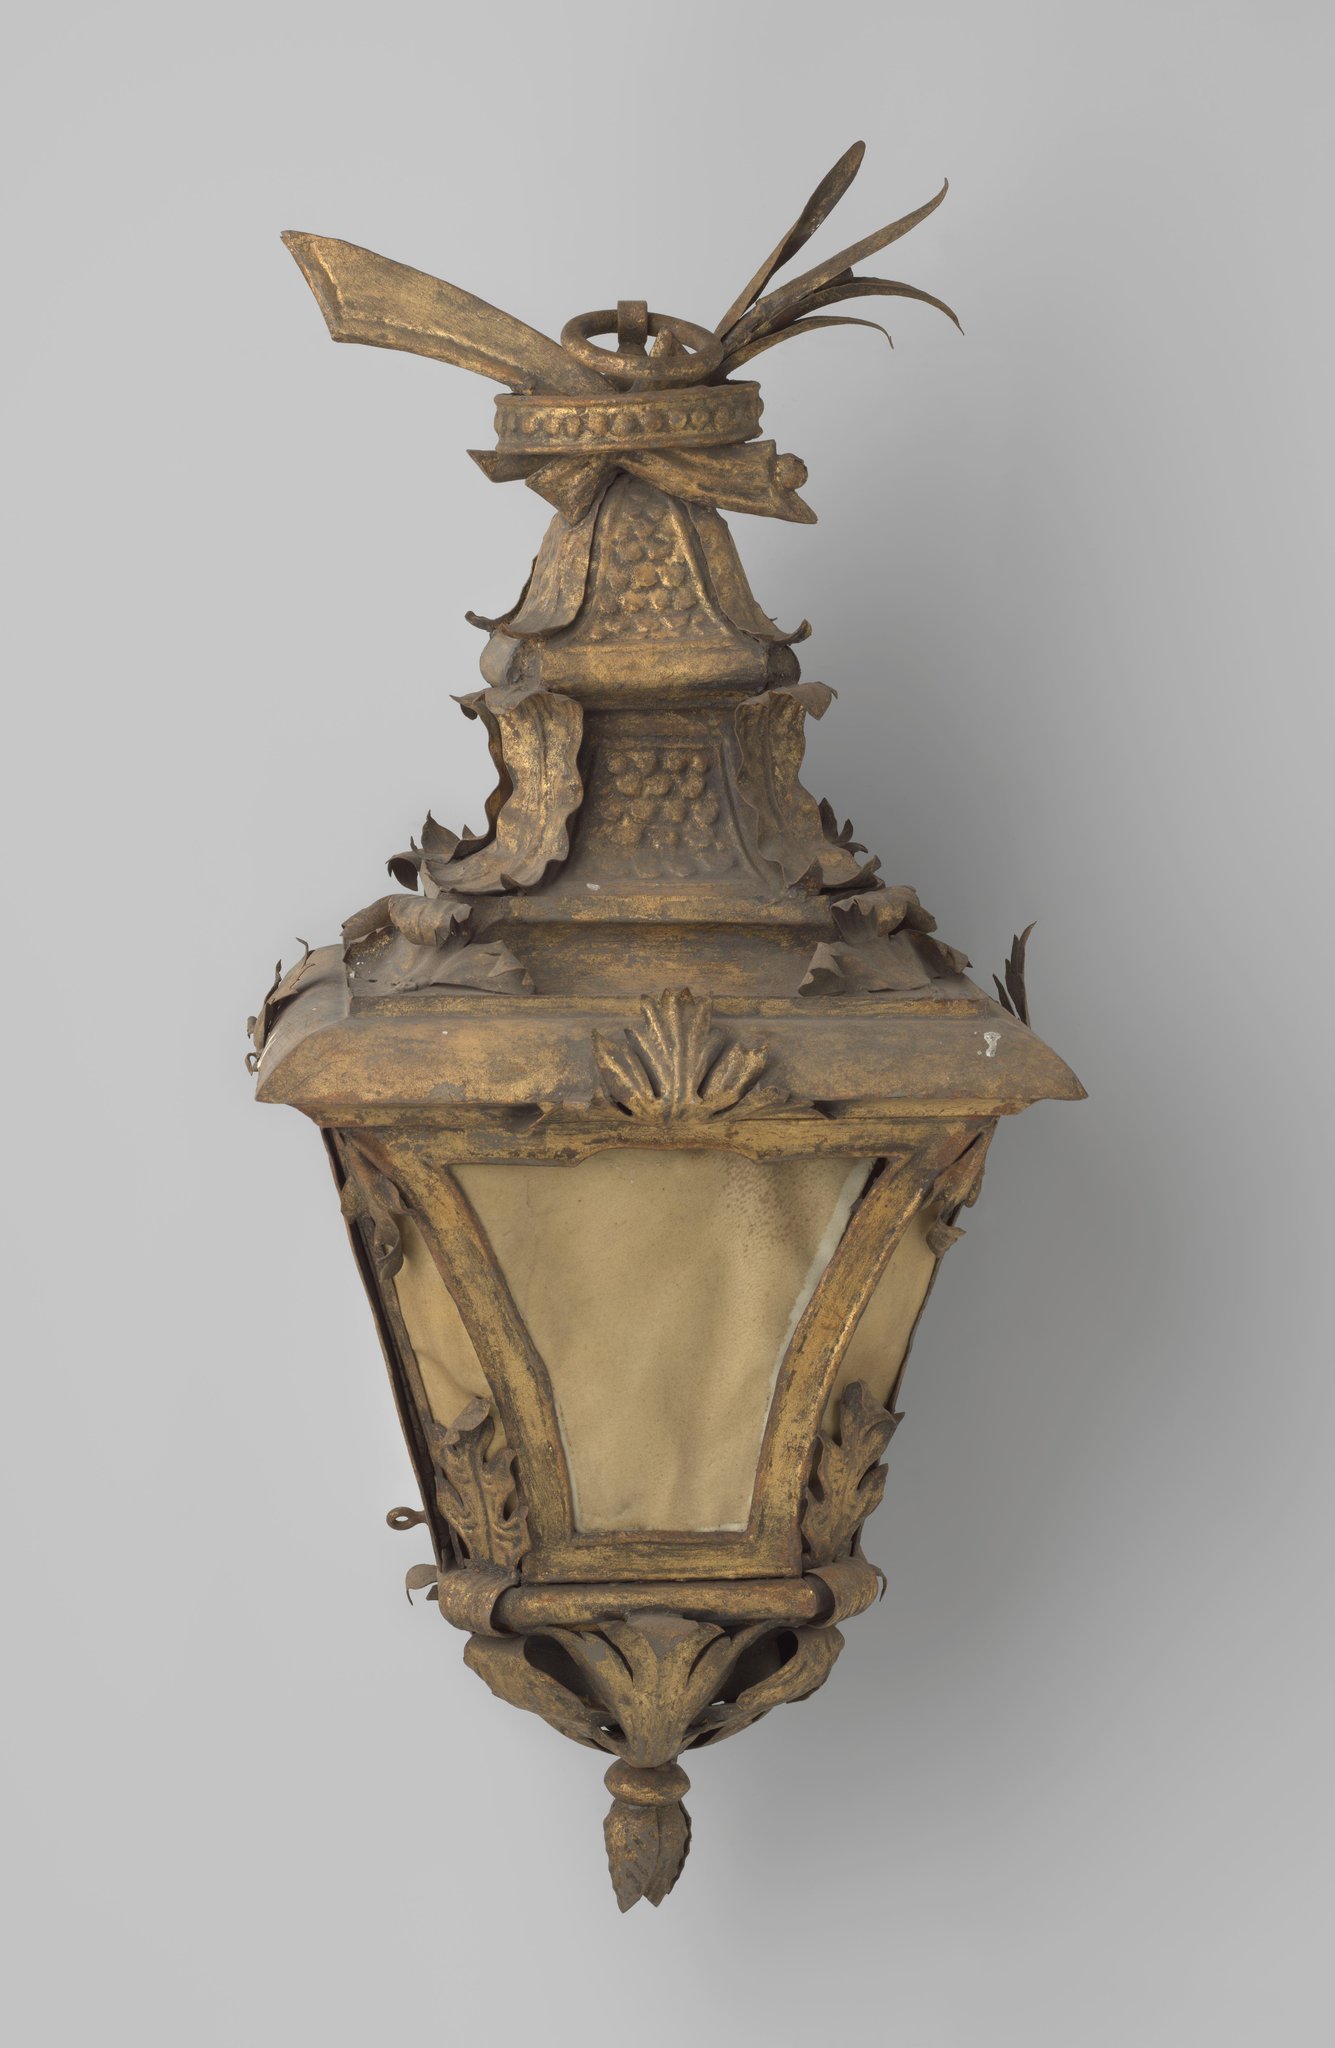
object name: lantern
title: Lantaarn, vierzijdig met afgeknotte hoeken en geleed dak, bekroond door platte ring waarin halmen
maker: Anonymous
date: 1725-1775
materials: iron, paper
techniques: gilding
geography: france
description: Een vierzijdig lantaarn met afgeknotte hoeken en een dak bestaande uit twee geledingen. Het dak wordt bekroond door een platte ring waarin zich enige halmen en een mes (?) bevinden. De lantaarn die zich geleidelijk naar onderen versmalt is hier en daar versierd met bladeren en eindigt in een bladkelk. Voor de ruiten geolied papier.